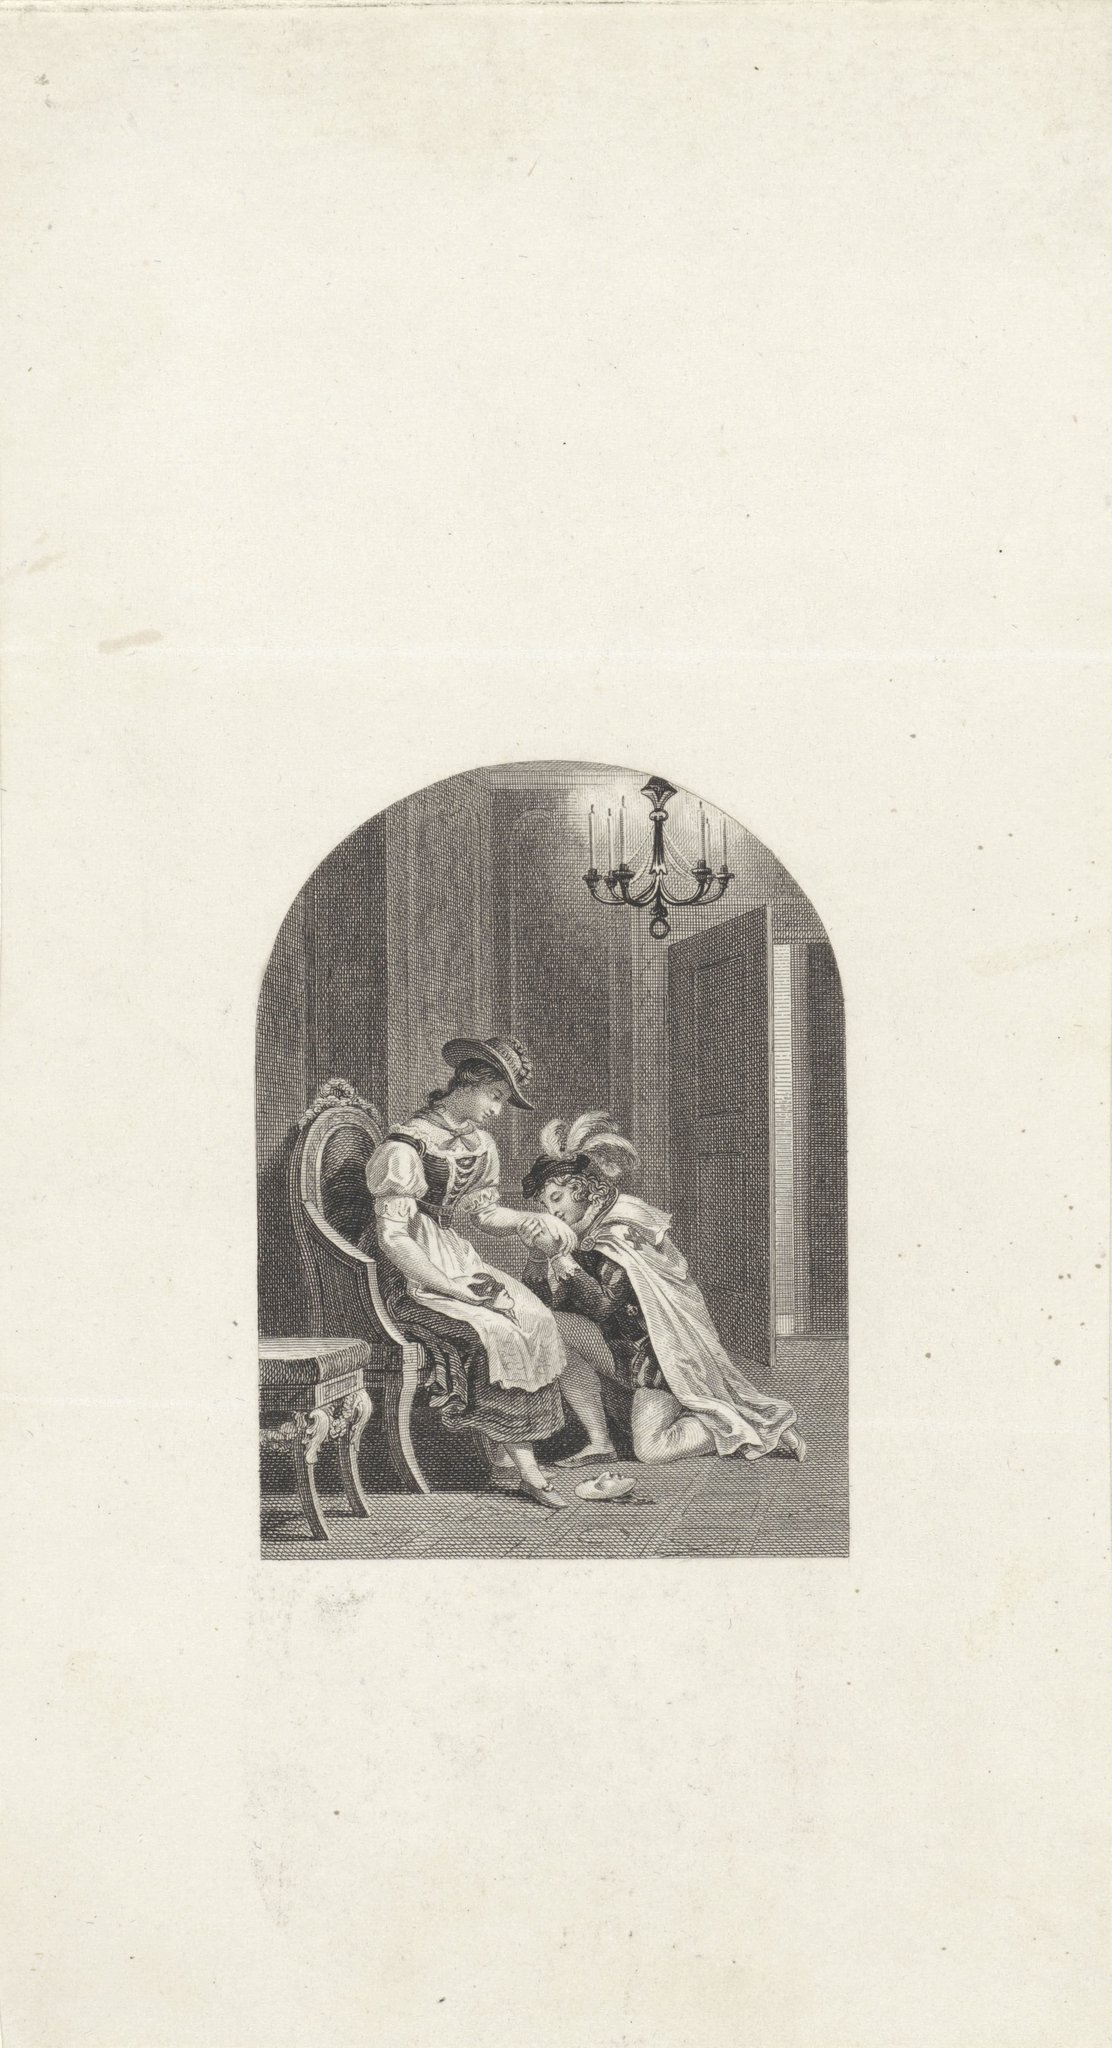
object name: print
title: Knielende man kust de hand van een zittende vrouw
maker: philippus velijn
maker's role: print maker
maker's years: 1787-1836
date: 1797-1836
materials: paper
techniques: engraving, etching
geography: netherlands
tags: mask, chandelier, candelabrum, kissing the hand (lovers)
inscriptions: collector's mark: Lugt 2228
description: Een knielende man met een cape om en veren op zijn muts, kust de hand van een zittende vrouw. Op de grond en in de hand van de vrouw een masker.